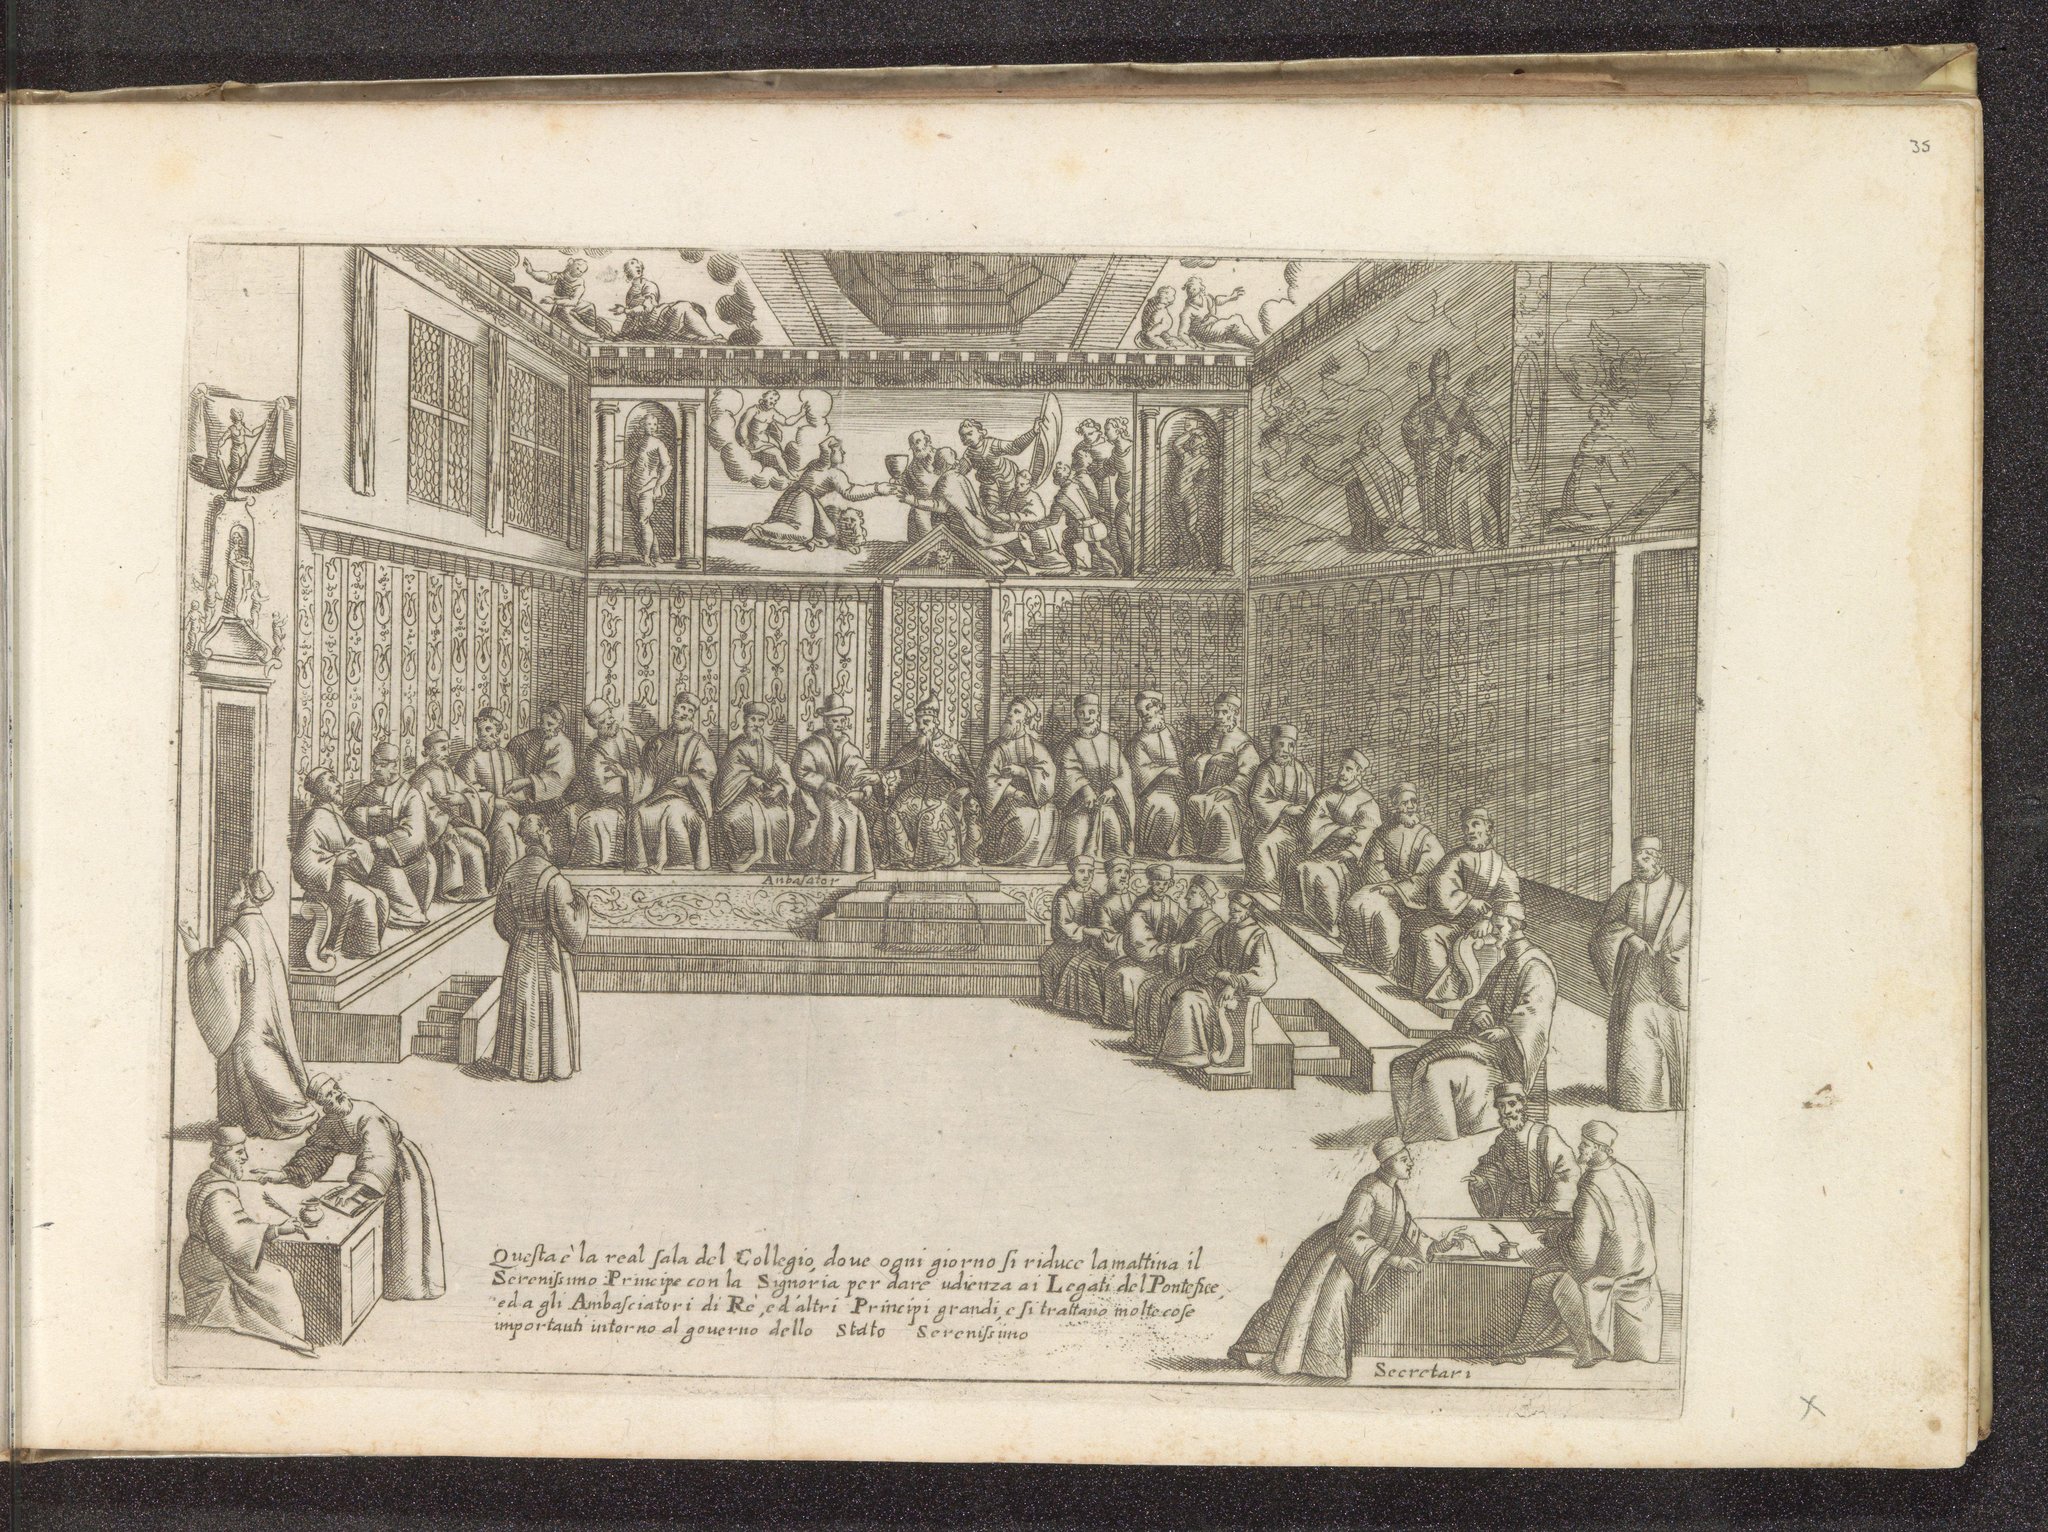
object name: album leaf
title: Scènes uit het Venetiaanse leven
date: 1610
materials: paper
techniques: engraving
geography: venice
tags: palace - aa - civic architecture: inside, other sovereign: doge, meeting, venice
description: Interieur van de Sala del Collegio in het Dogepaleis te Venetië. De doge van Venetië zit in het midden en leidt een vergadering. Vierregelige Italiaanse tekst midden onder. De prent maakt deel uit van een album.